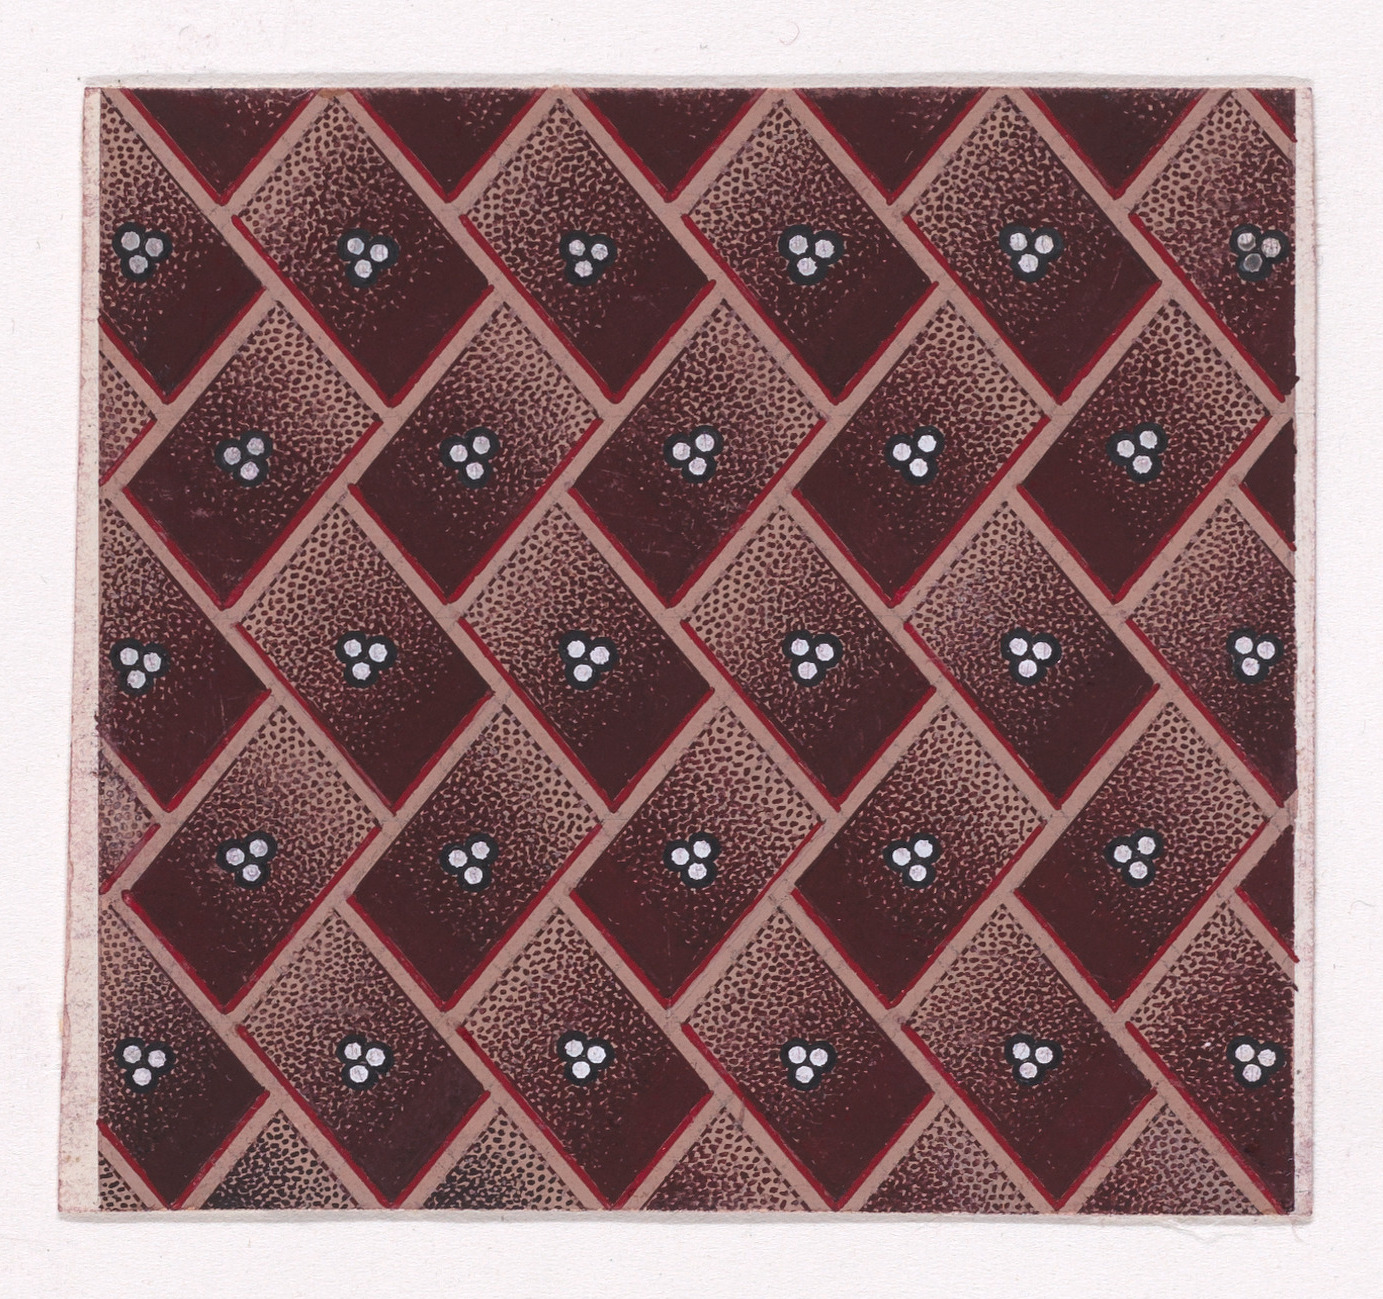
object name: drawing ornament architecture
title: Textile Design with a Tiled Background of Alternating Rectangular Shapes Framed by Ribbons Decorated with Trefoils of Pearls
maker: anonymous, alsatian, 19th century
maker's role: artist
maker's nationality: alsatian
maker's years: 1800-1900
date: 1840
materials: gouache